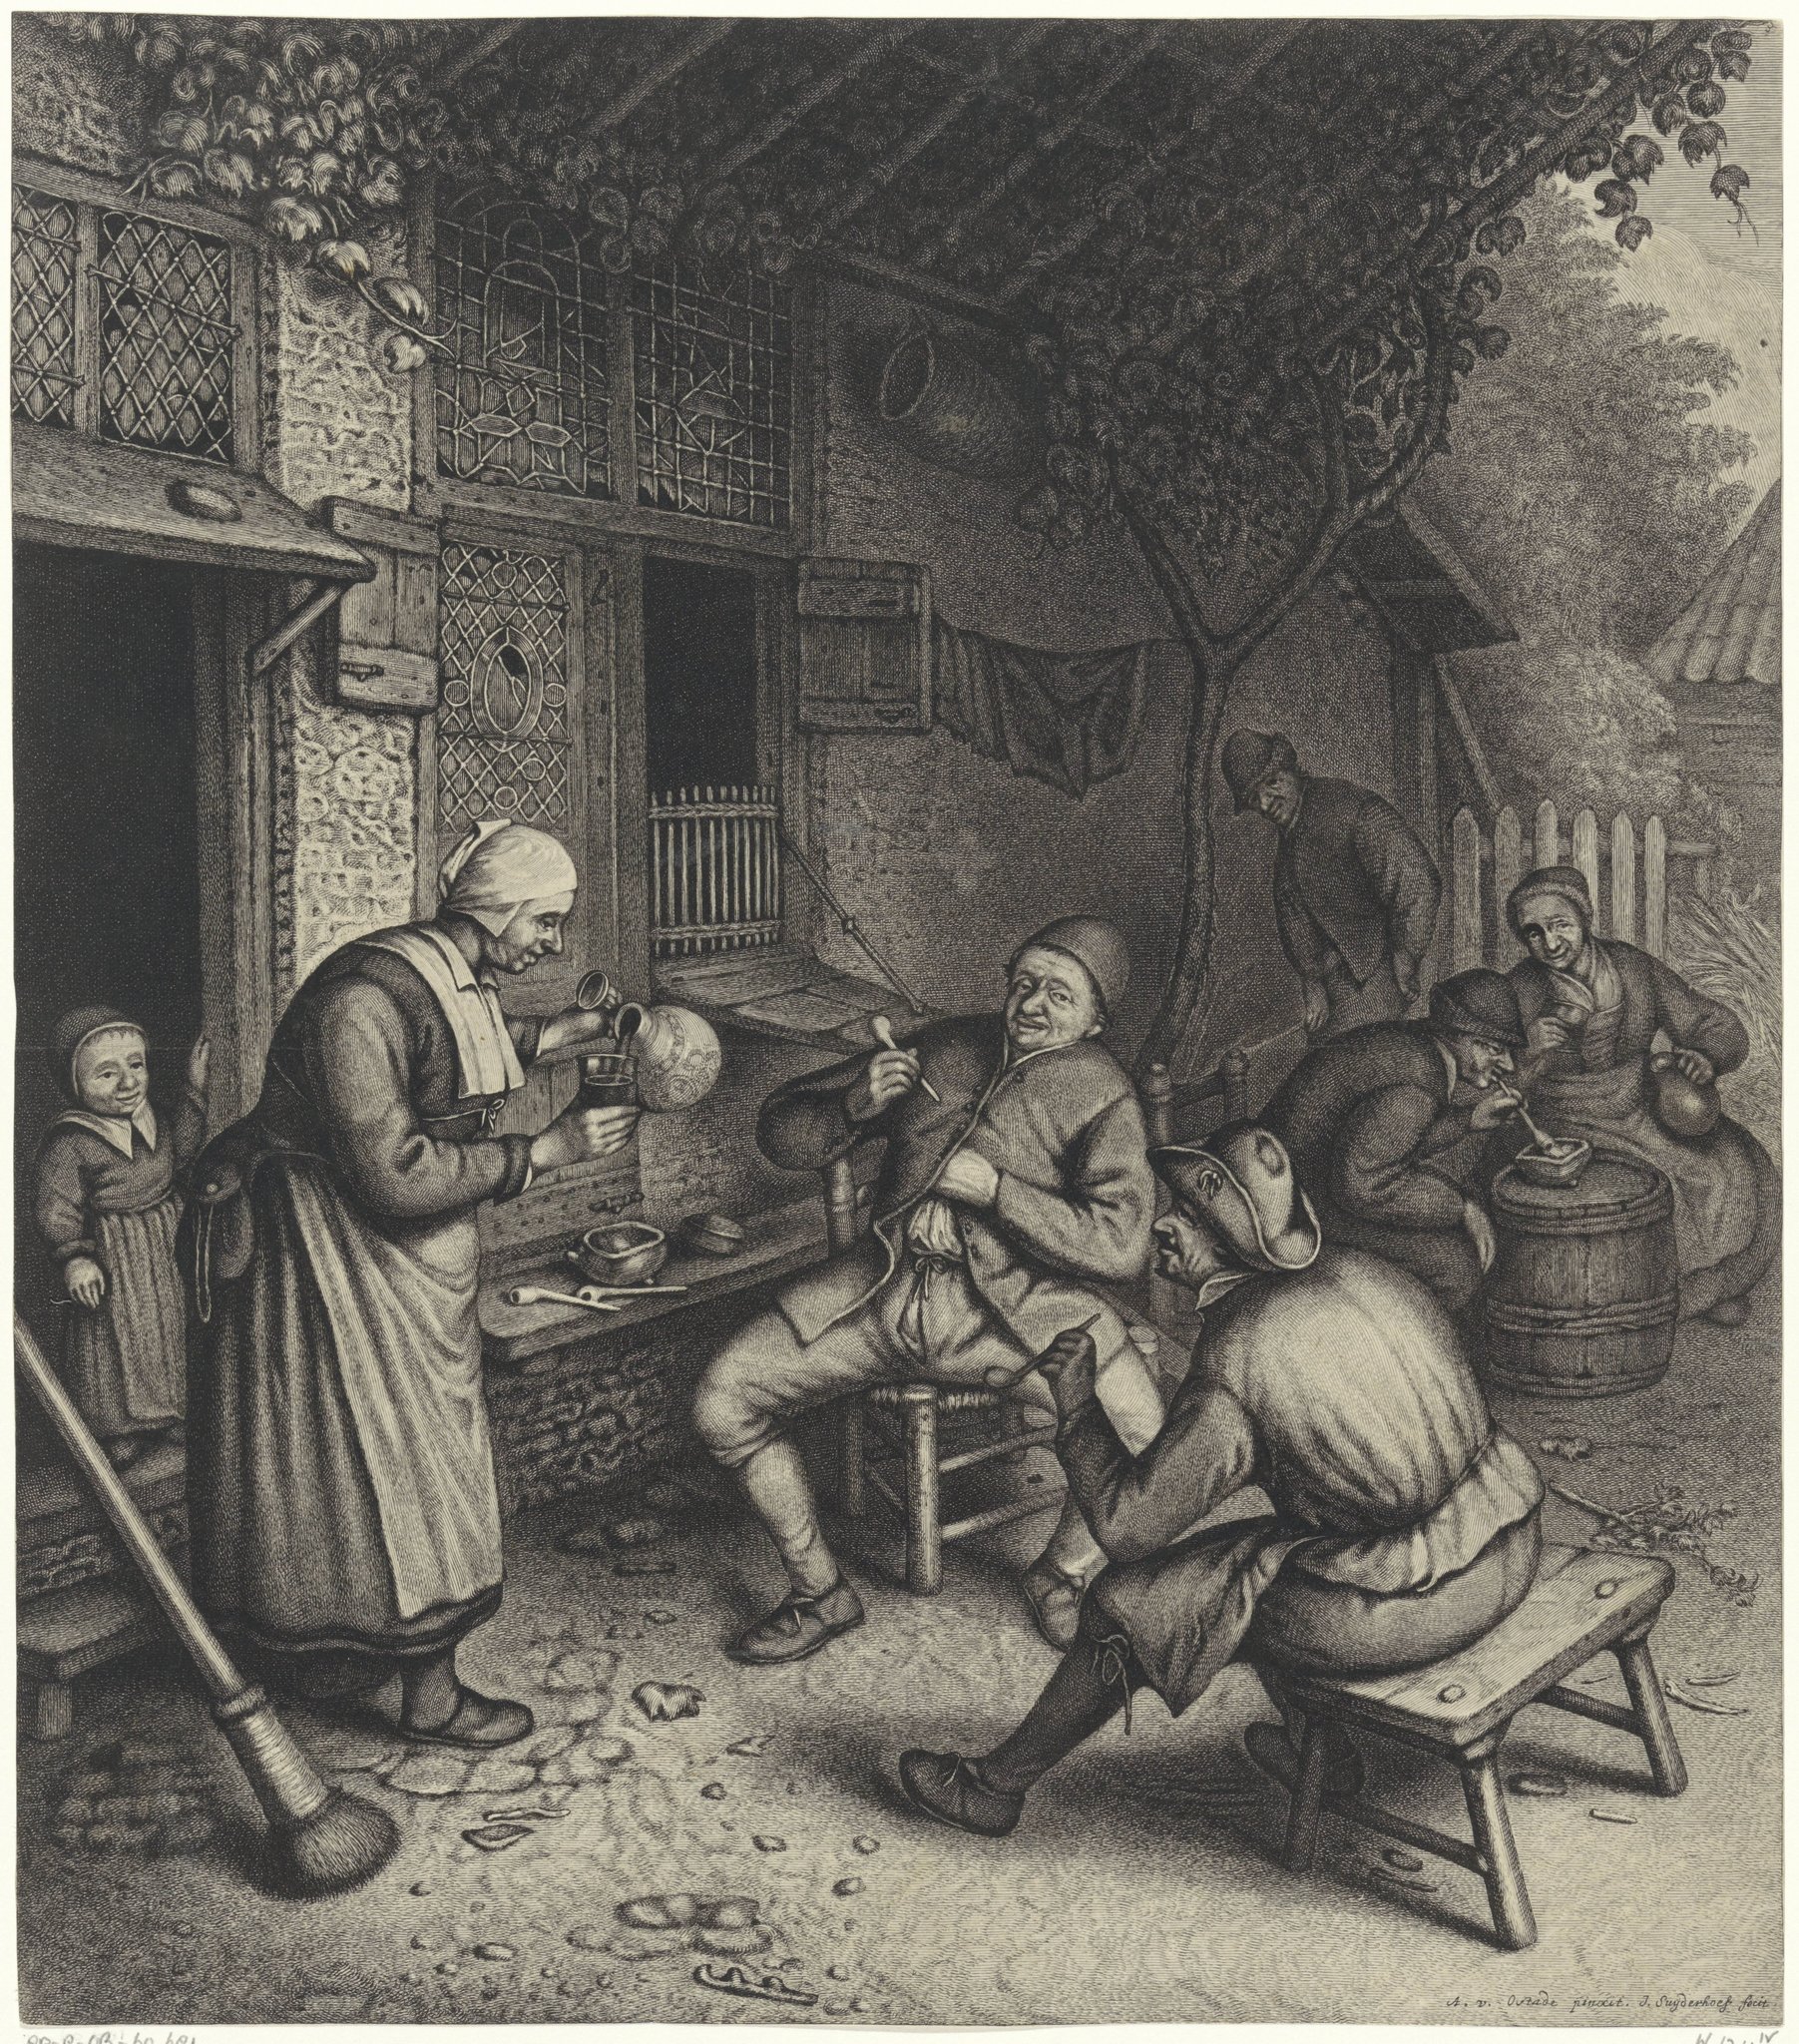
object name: print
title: Boeren op het terras voor een herberg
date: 1623-1686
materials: paper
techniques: engraving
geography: haarlem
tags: child, inn, coffee-house, public house, etc., pipe ~ tobacco, shrubs: broom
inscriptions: collector's mark: Lugt 240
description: Voor een herberg zitten twee boeren, ieder met een pijp in de hand. Een vrouw schenkt een glas vol. In de deuropening een kind. Rechts een staande man en een man en een vrouw bij een ton.